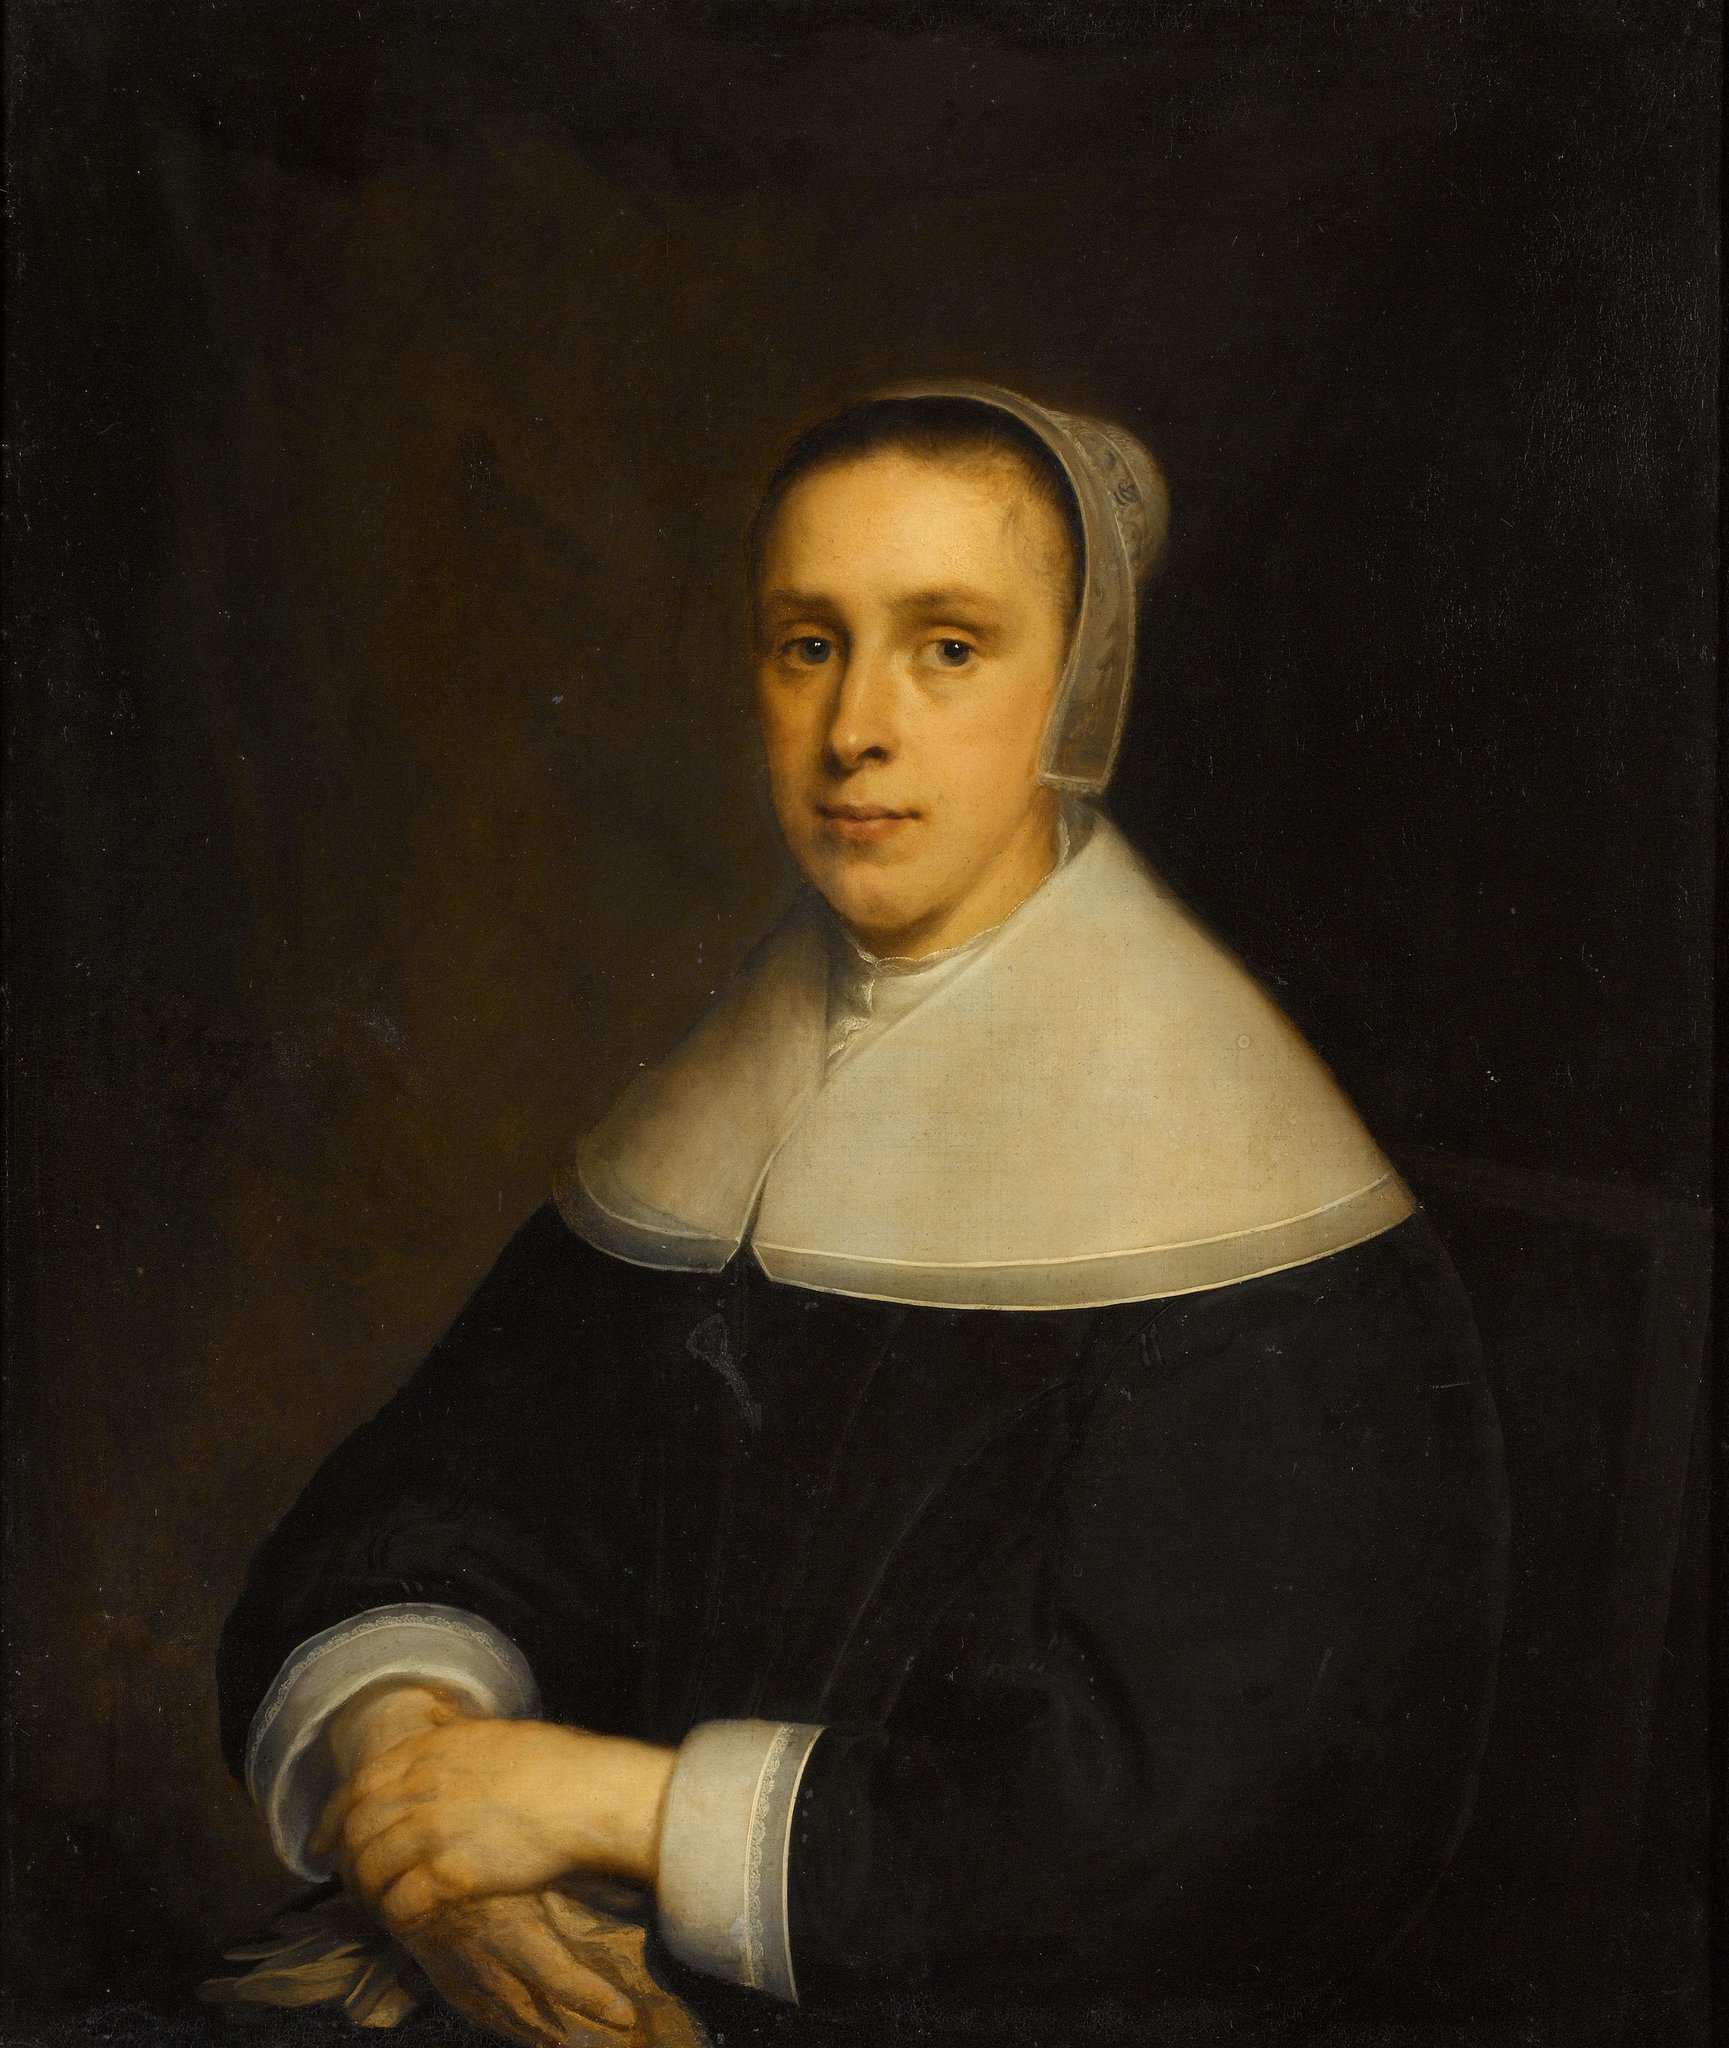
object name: painting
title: Portrait of Elisabeth Vervoorn (1617-73), Wife of Johan van Someren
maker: cornelis janssens van ceulen i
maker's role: draughtsman, painter, print maker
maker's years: 1593-1661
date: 1650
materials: canvas, oil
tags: nijmegen, historical persons - bb - woman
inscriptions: label, on the reverse: ‘Elizabeth Vervoorn / geboren 9 September 1617 / overleden 17 October 1657 / trouwt 9 Mei 1648. met / Mr. Johan van Someren / geboren 3 Juli 1622 / Raad Pensionaris van Nij[...] / hebb[...] / geboren [...] / trouwt [...] / Mr. Zeger[...] / Hoven va[...] / geboren [...]’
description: Portret van Elisabeth Vervoorn, sinds 1648 (tweede) echtgenote van Johannes van Someren. Zittend, ten halven lijve, handschoenen in de rechterhand en de met de handen in de schoot. Pendant van SK-A-3857.